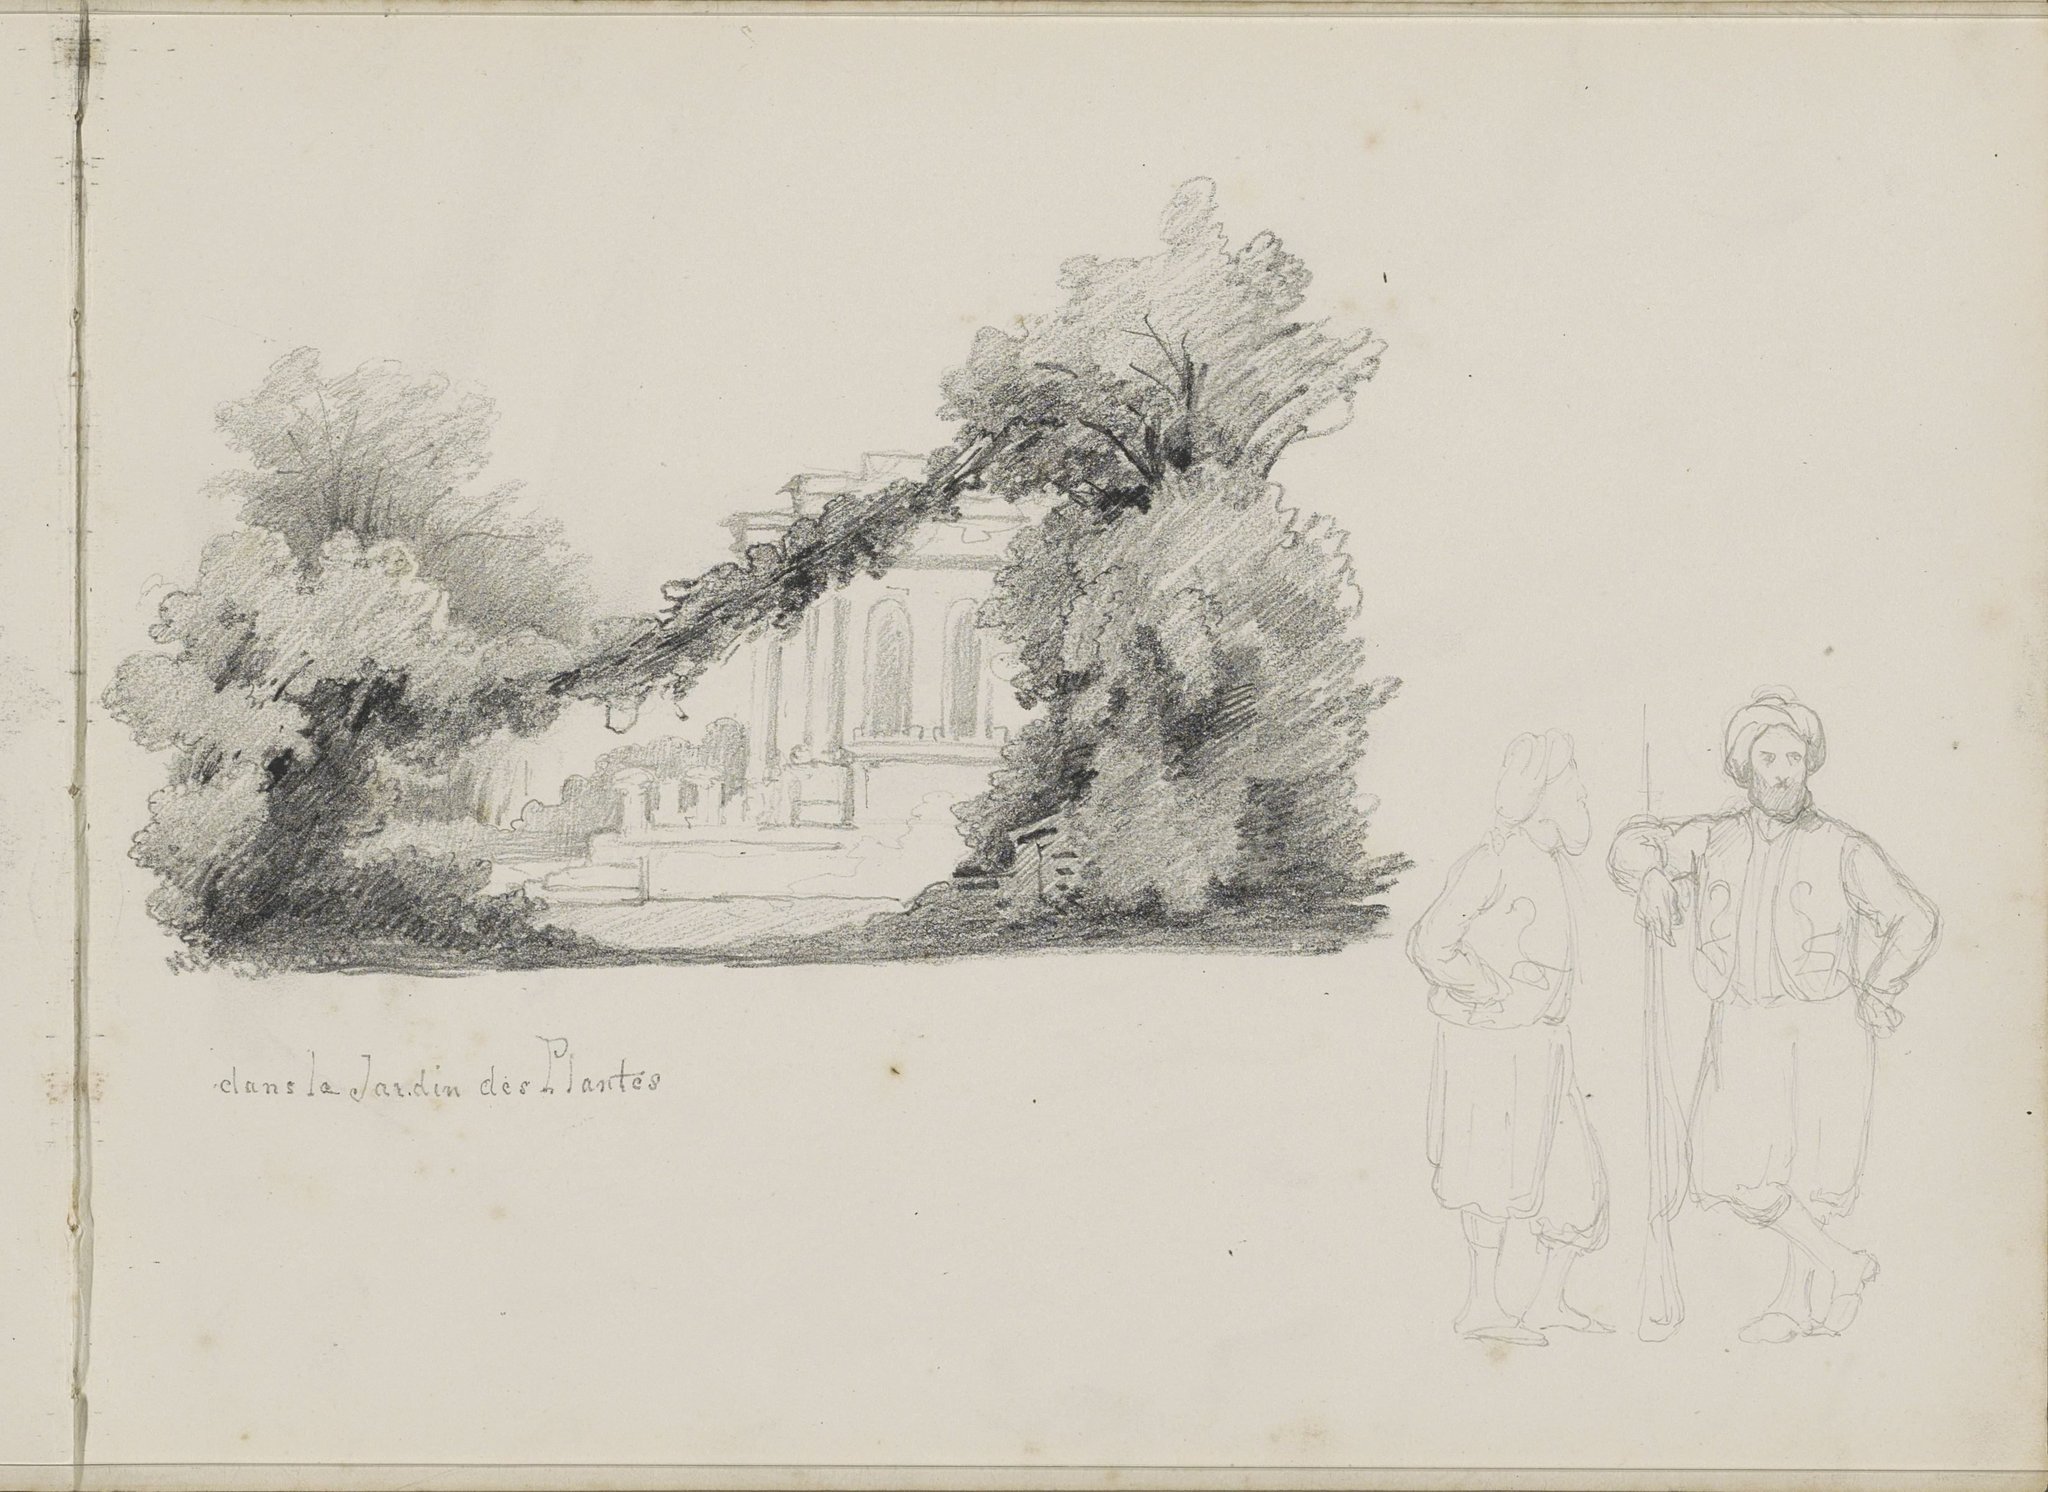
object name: sketchbook leaf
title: Gebouw in de Jardin des Plantes te Parijs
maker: gerrit postma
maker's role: draughtsman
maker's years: 1819-1894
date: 1858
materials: paper, pencil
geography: paris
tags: standing figure, head-gear: turban (+ men's clothes), botanic garden, 'hortus botanicus'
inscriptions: annotation: ‘dans la Jardin des Plantes’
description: Tevens een studie van twee bebaarde mannen met pofbroeken en tulbanden. Eén van de mannen leunt op een geweer. Blad 14 recto uit een schetsboek met 52 bladen.